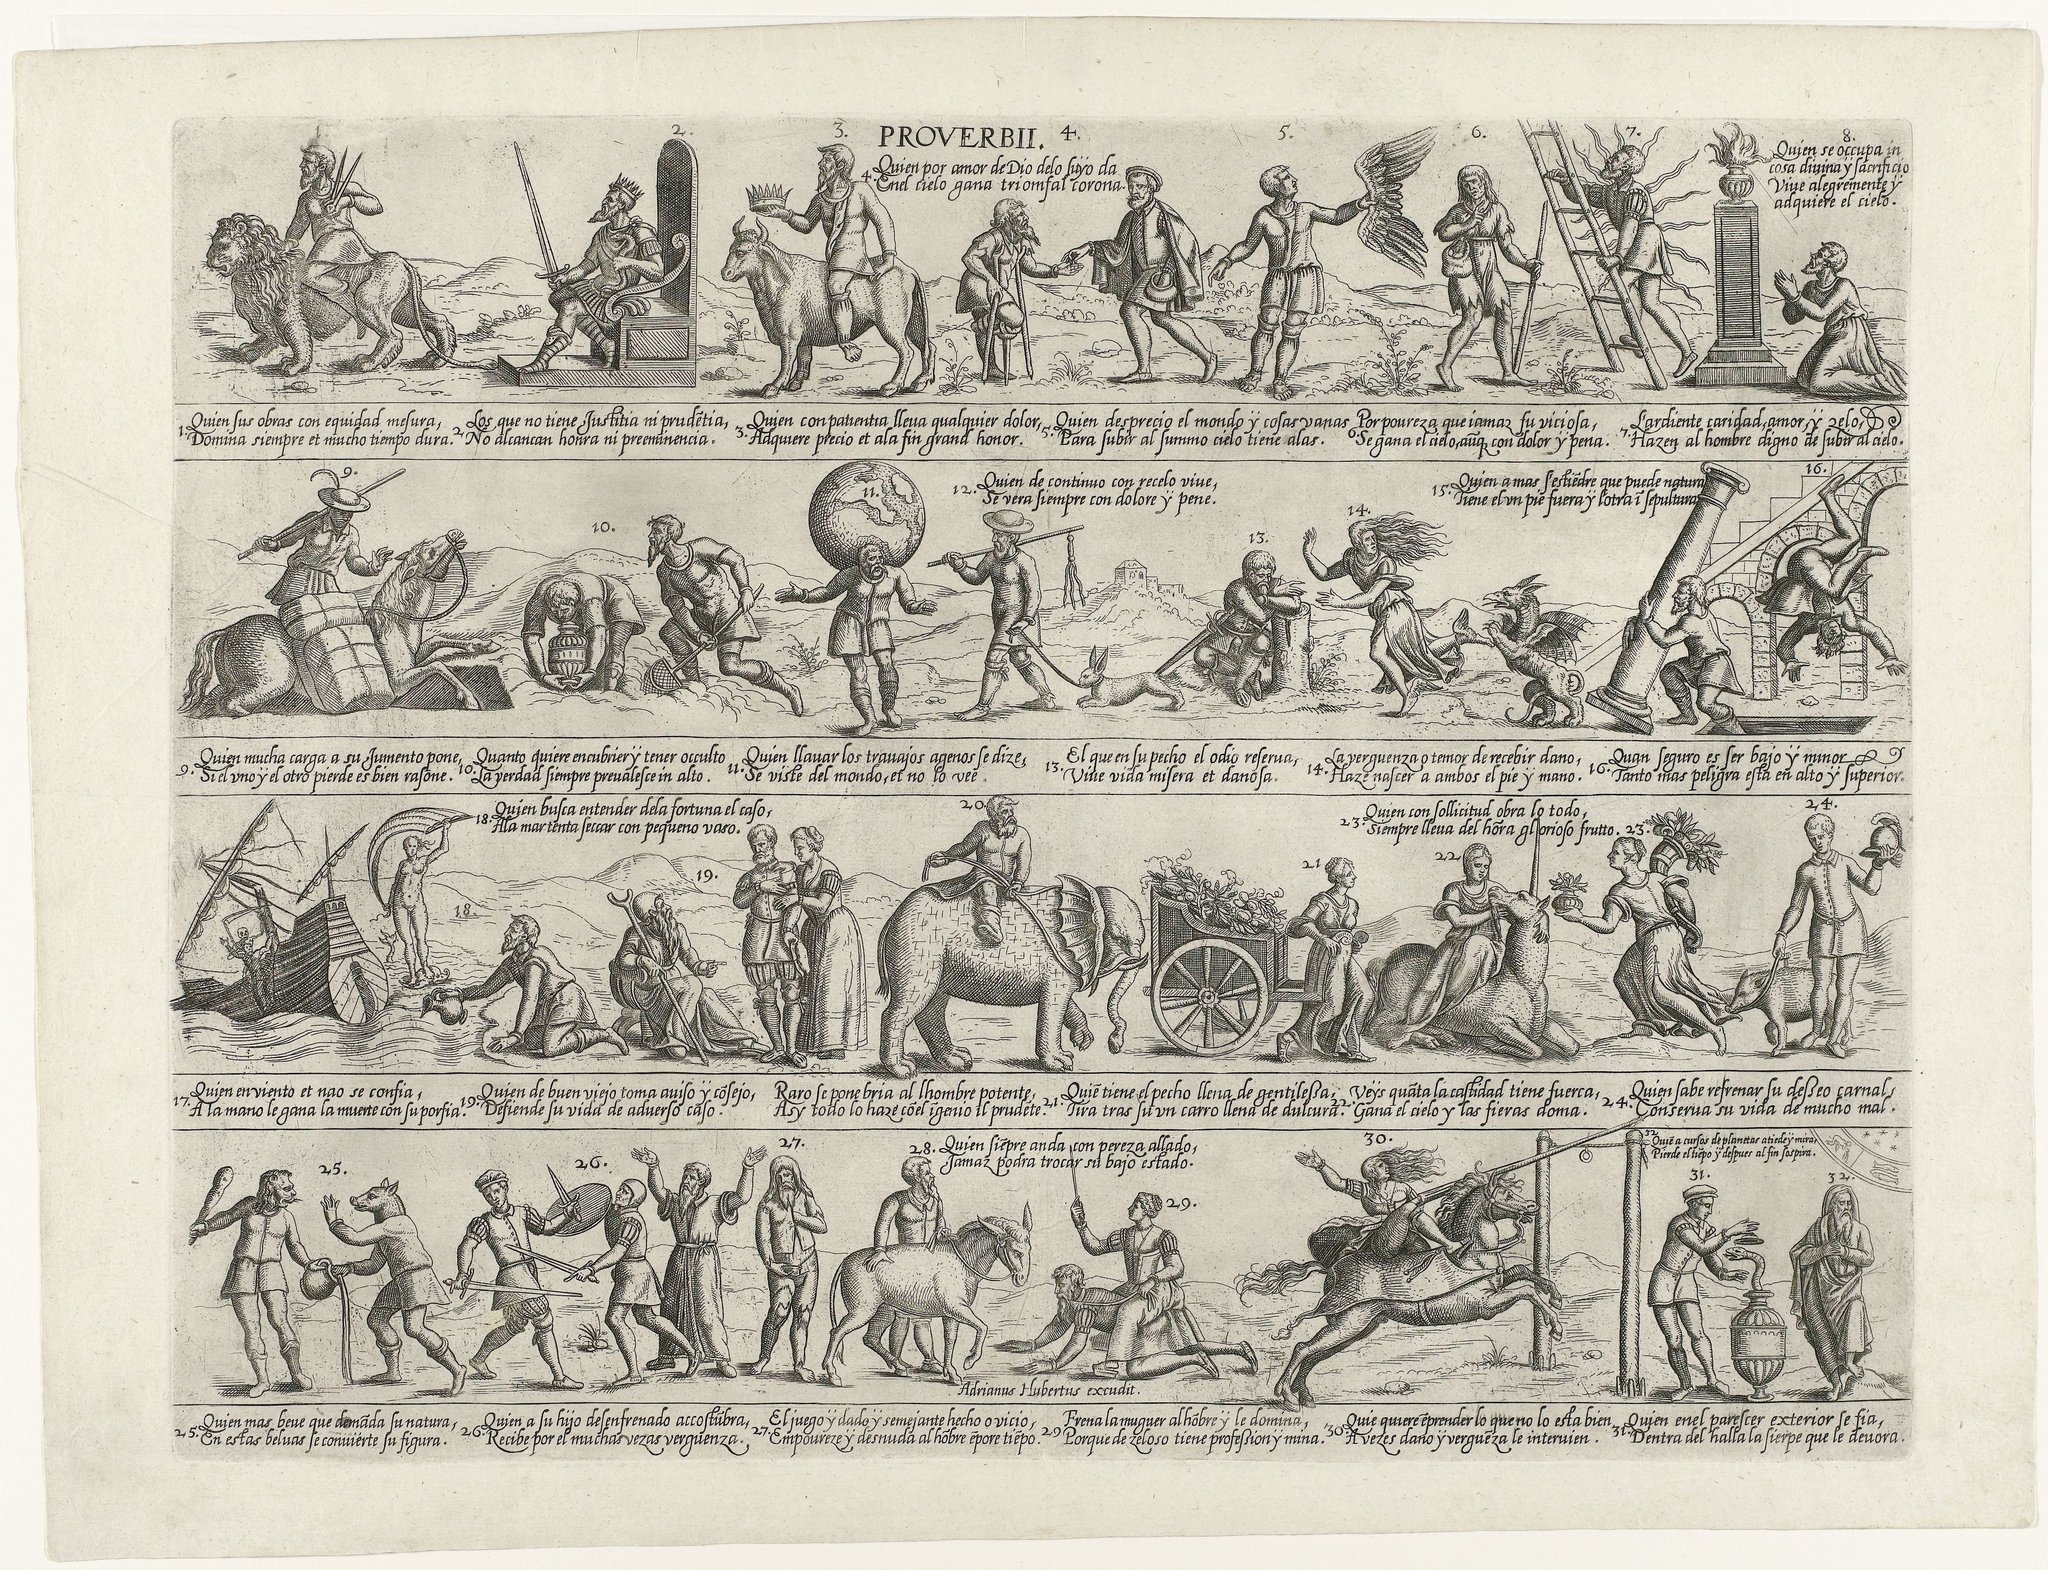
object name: print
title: PROVERBII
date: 1560-1590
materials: paper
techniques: engraving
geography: antwerp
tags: proverbs, sayings, etc.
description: Tweeëndertig kleine, genummerde voorstellingen met verbeeldingen van spreekwoorden. Iedere scène is voorzien van twee regels Spaanse tekst.